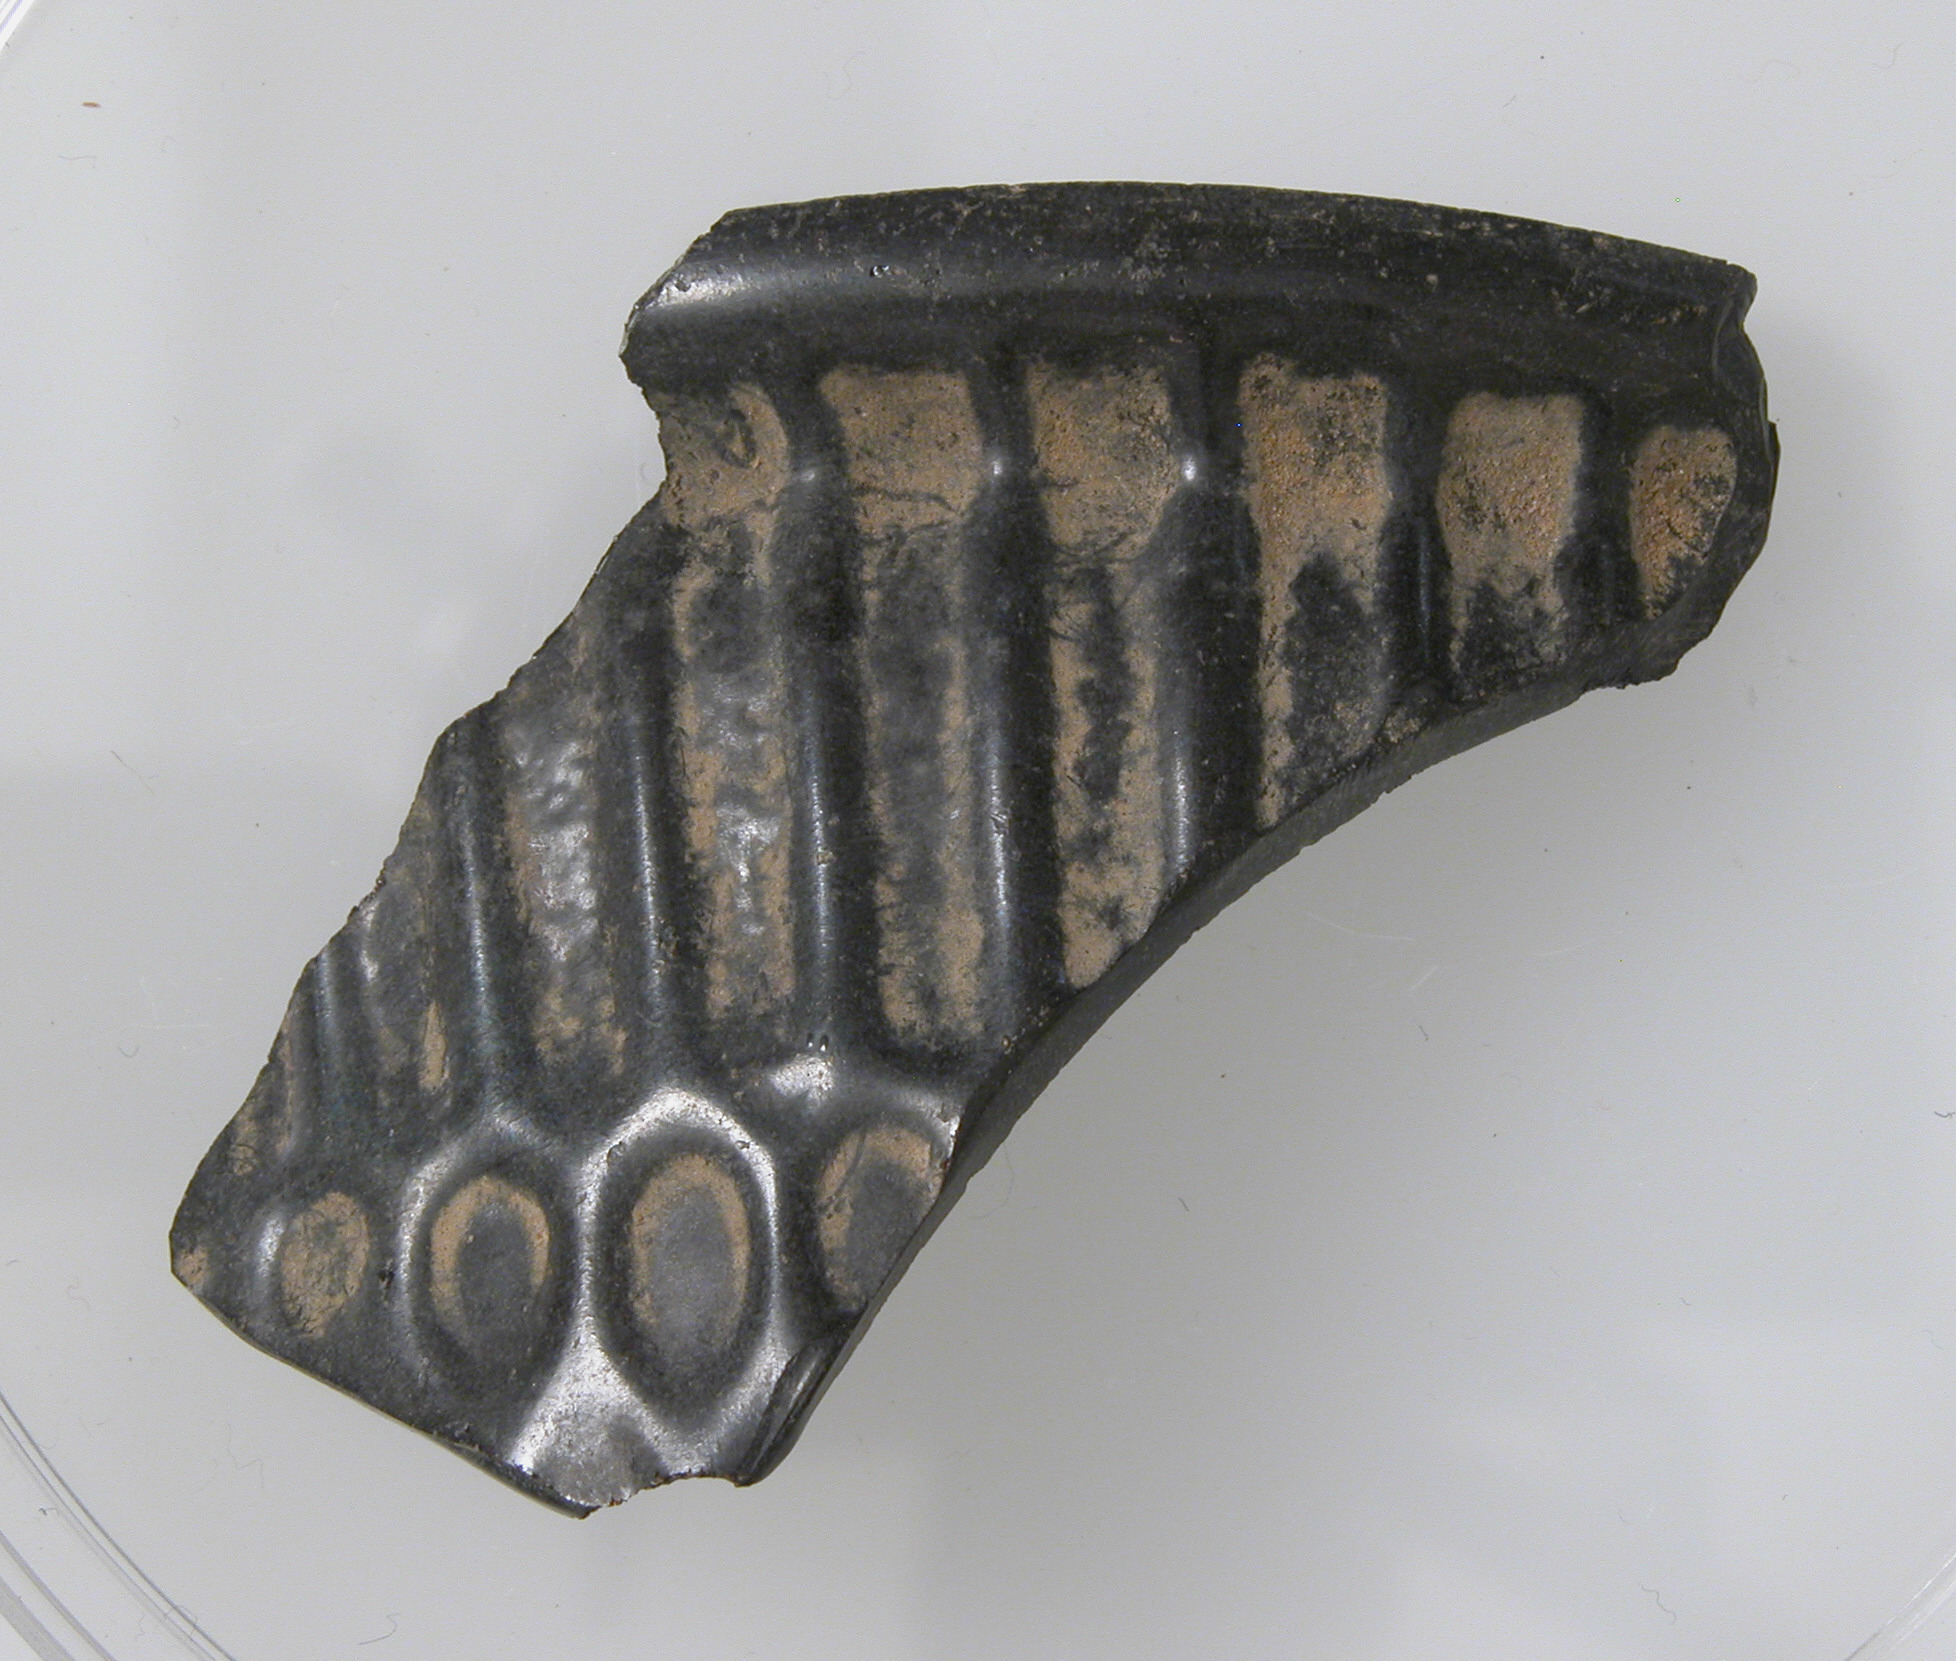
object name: fragment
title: Glass Fragment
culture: coptic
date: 301-433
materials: glass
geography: egypt